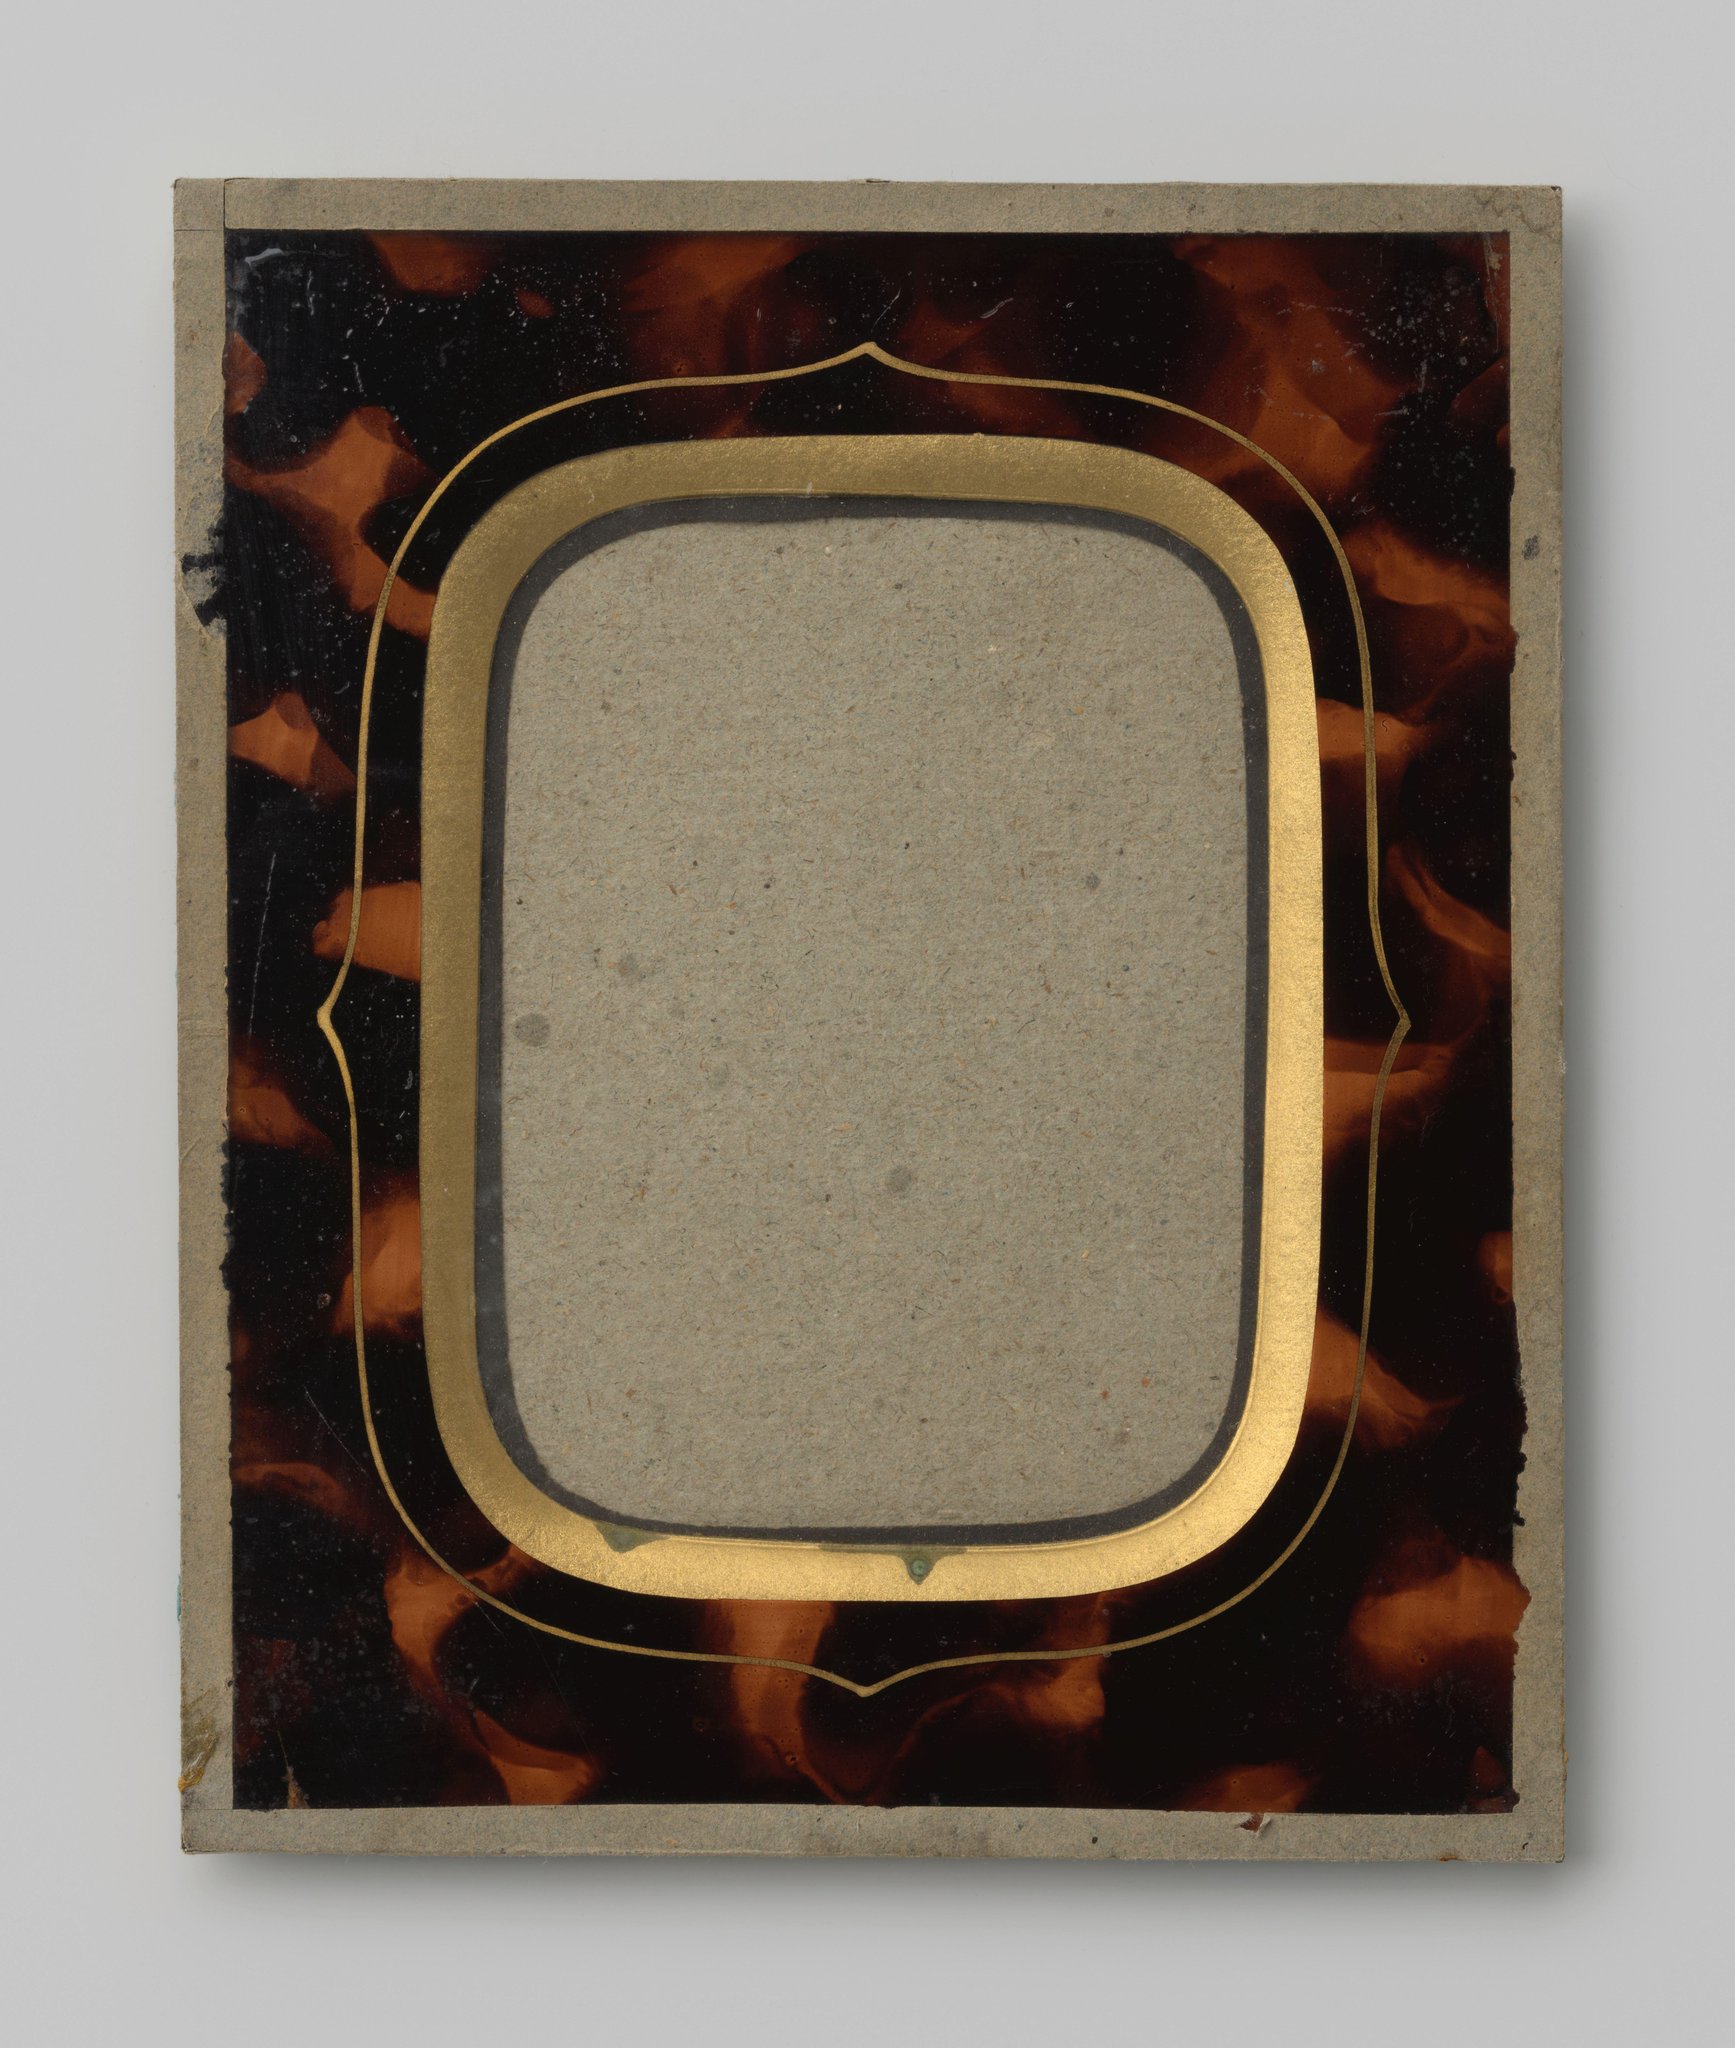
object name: frame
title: Lijst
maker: Anonymous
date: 1880-1900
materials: cardboard, glass